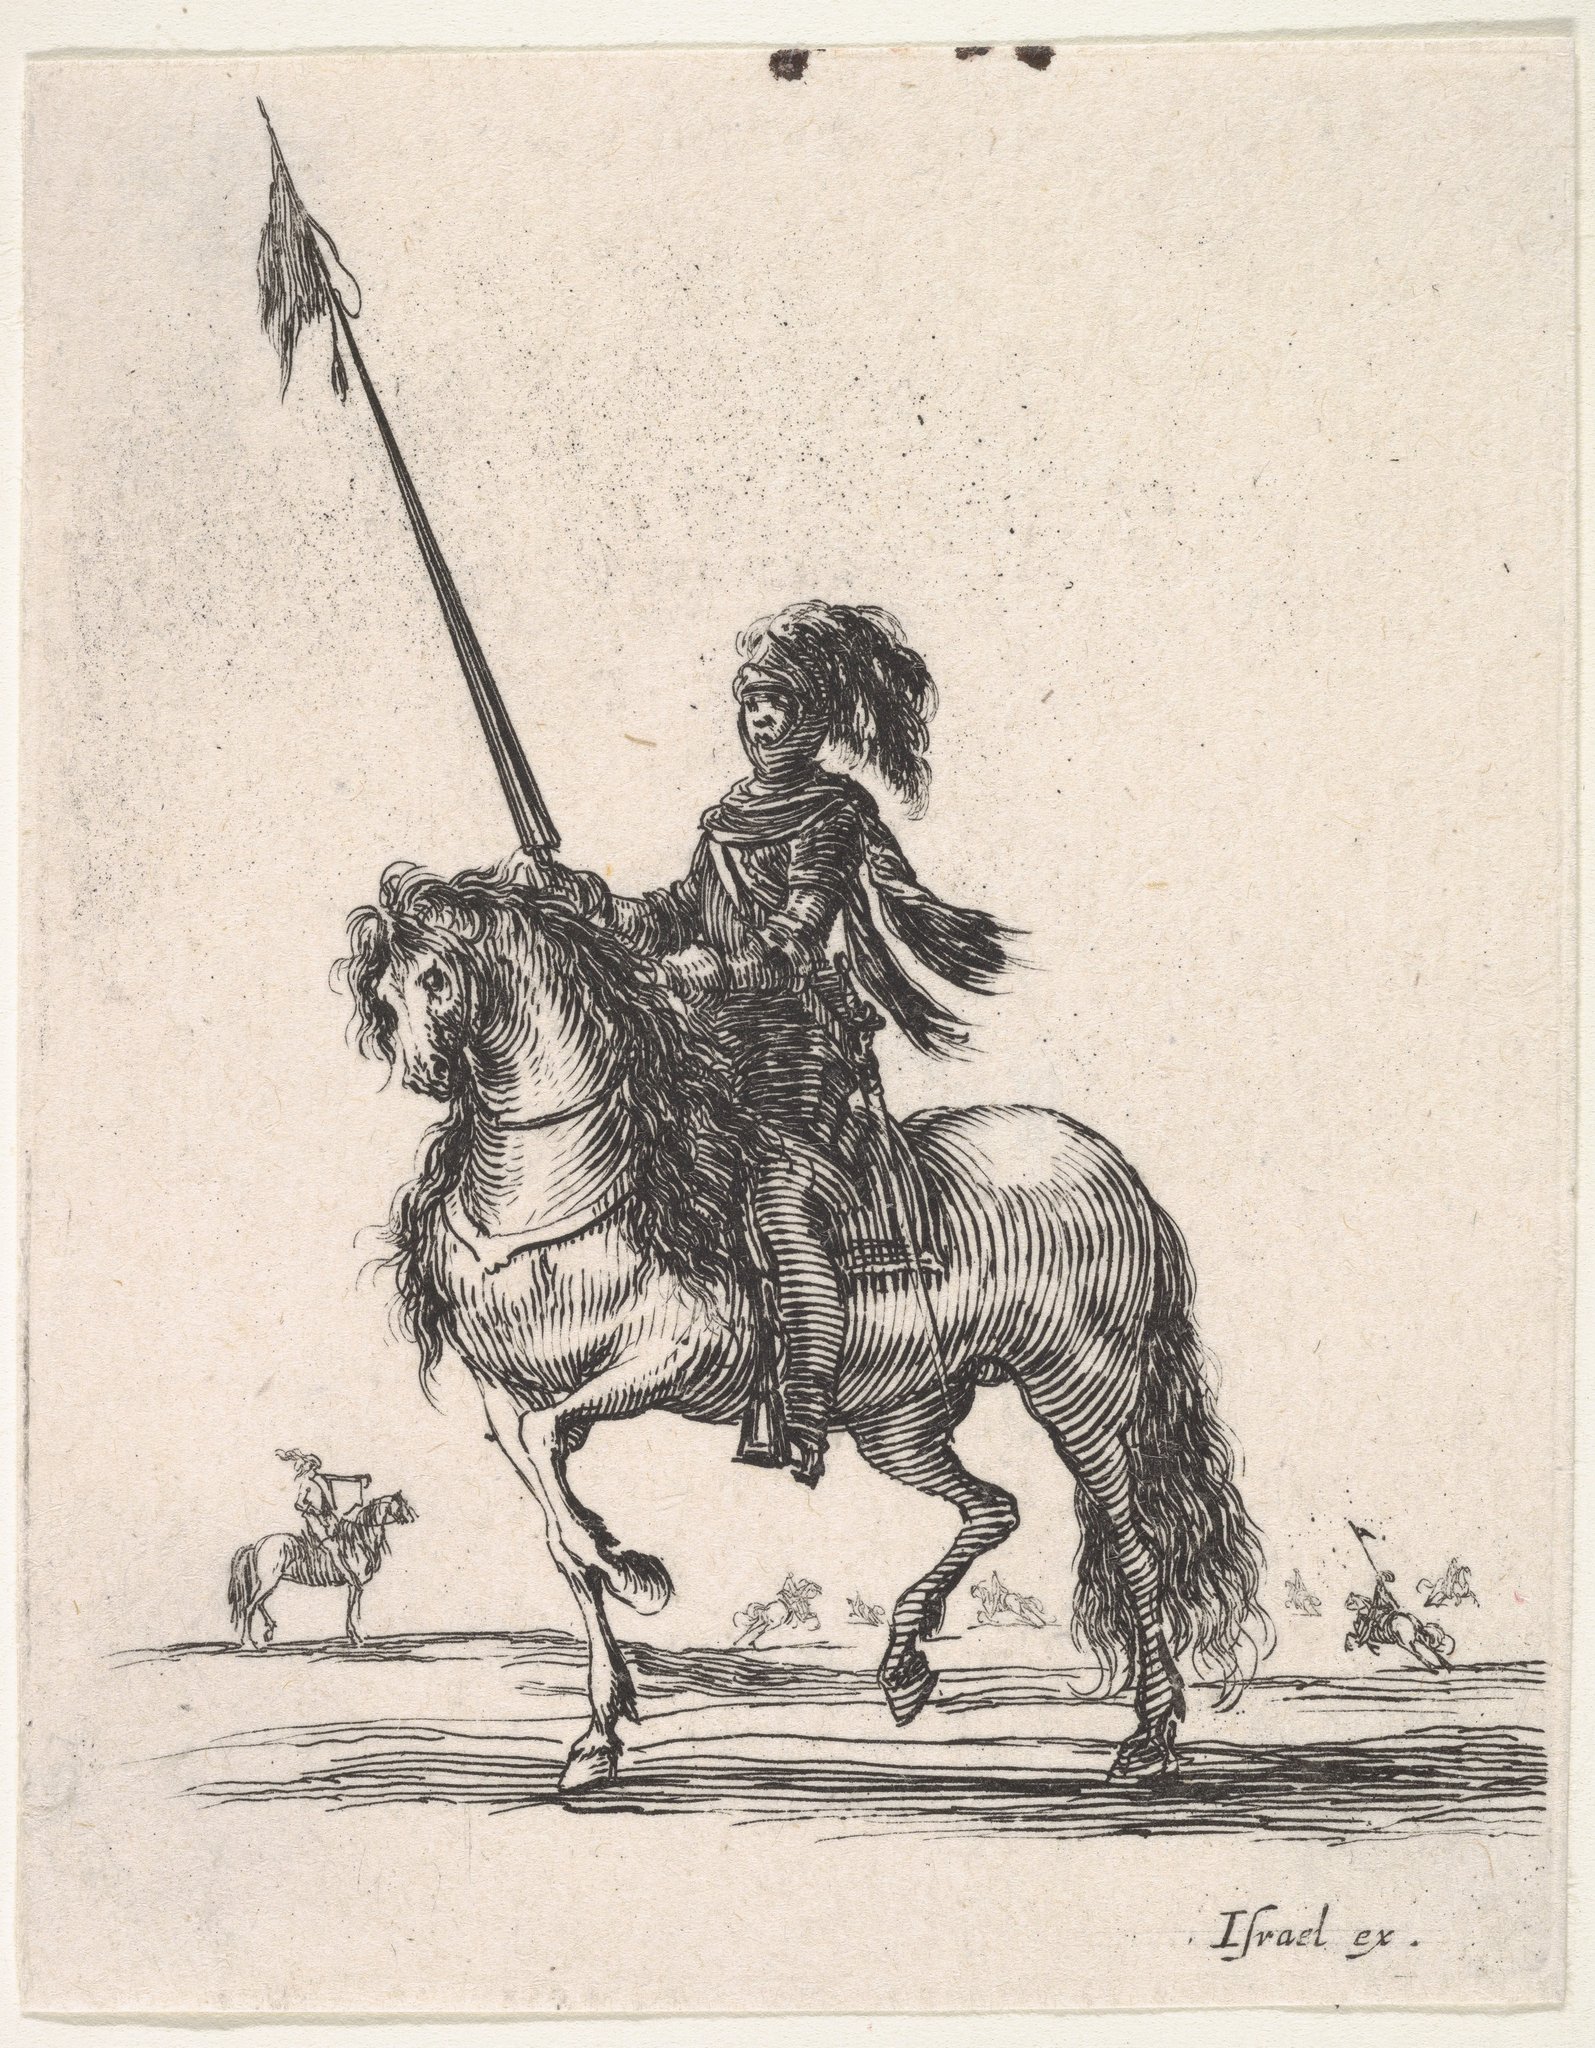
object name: print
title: Mounted cuirassier holding a lance upright and riding towards left, other horsemen in the background, from "Various cavalry exercises" (Diverses exercices de cavalerie)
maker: stefano della bella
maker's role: artist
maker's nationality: italian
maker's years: 1610-1664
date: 1642-1645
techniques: etching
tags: soldiers,weapons,men,horses